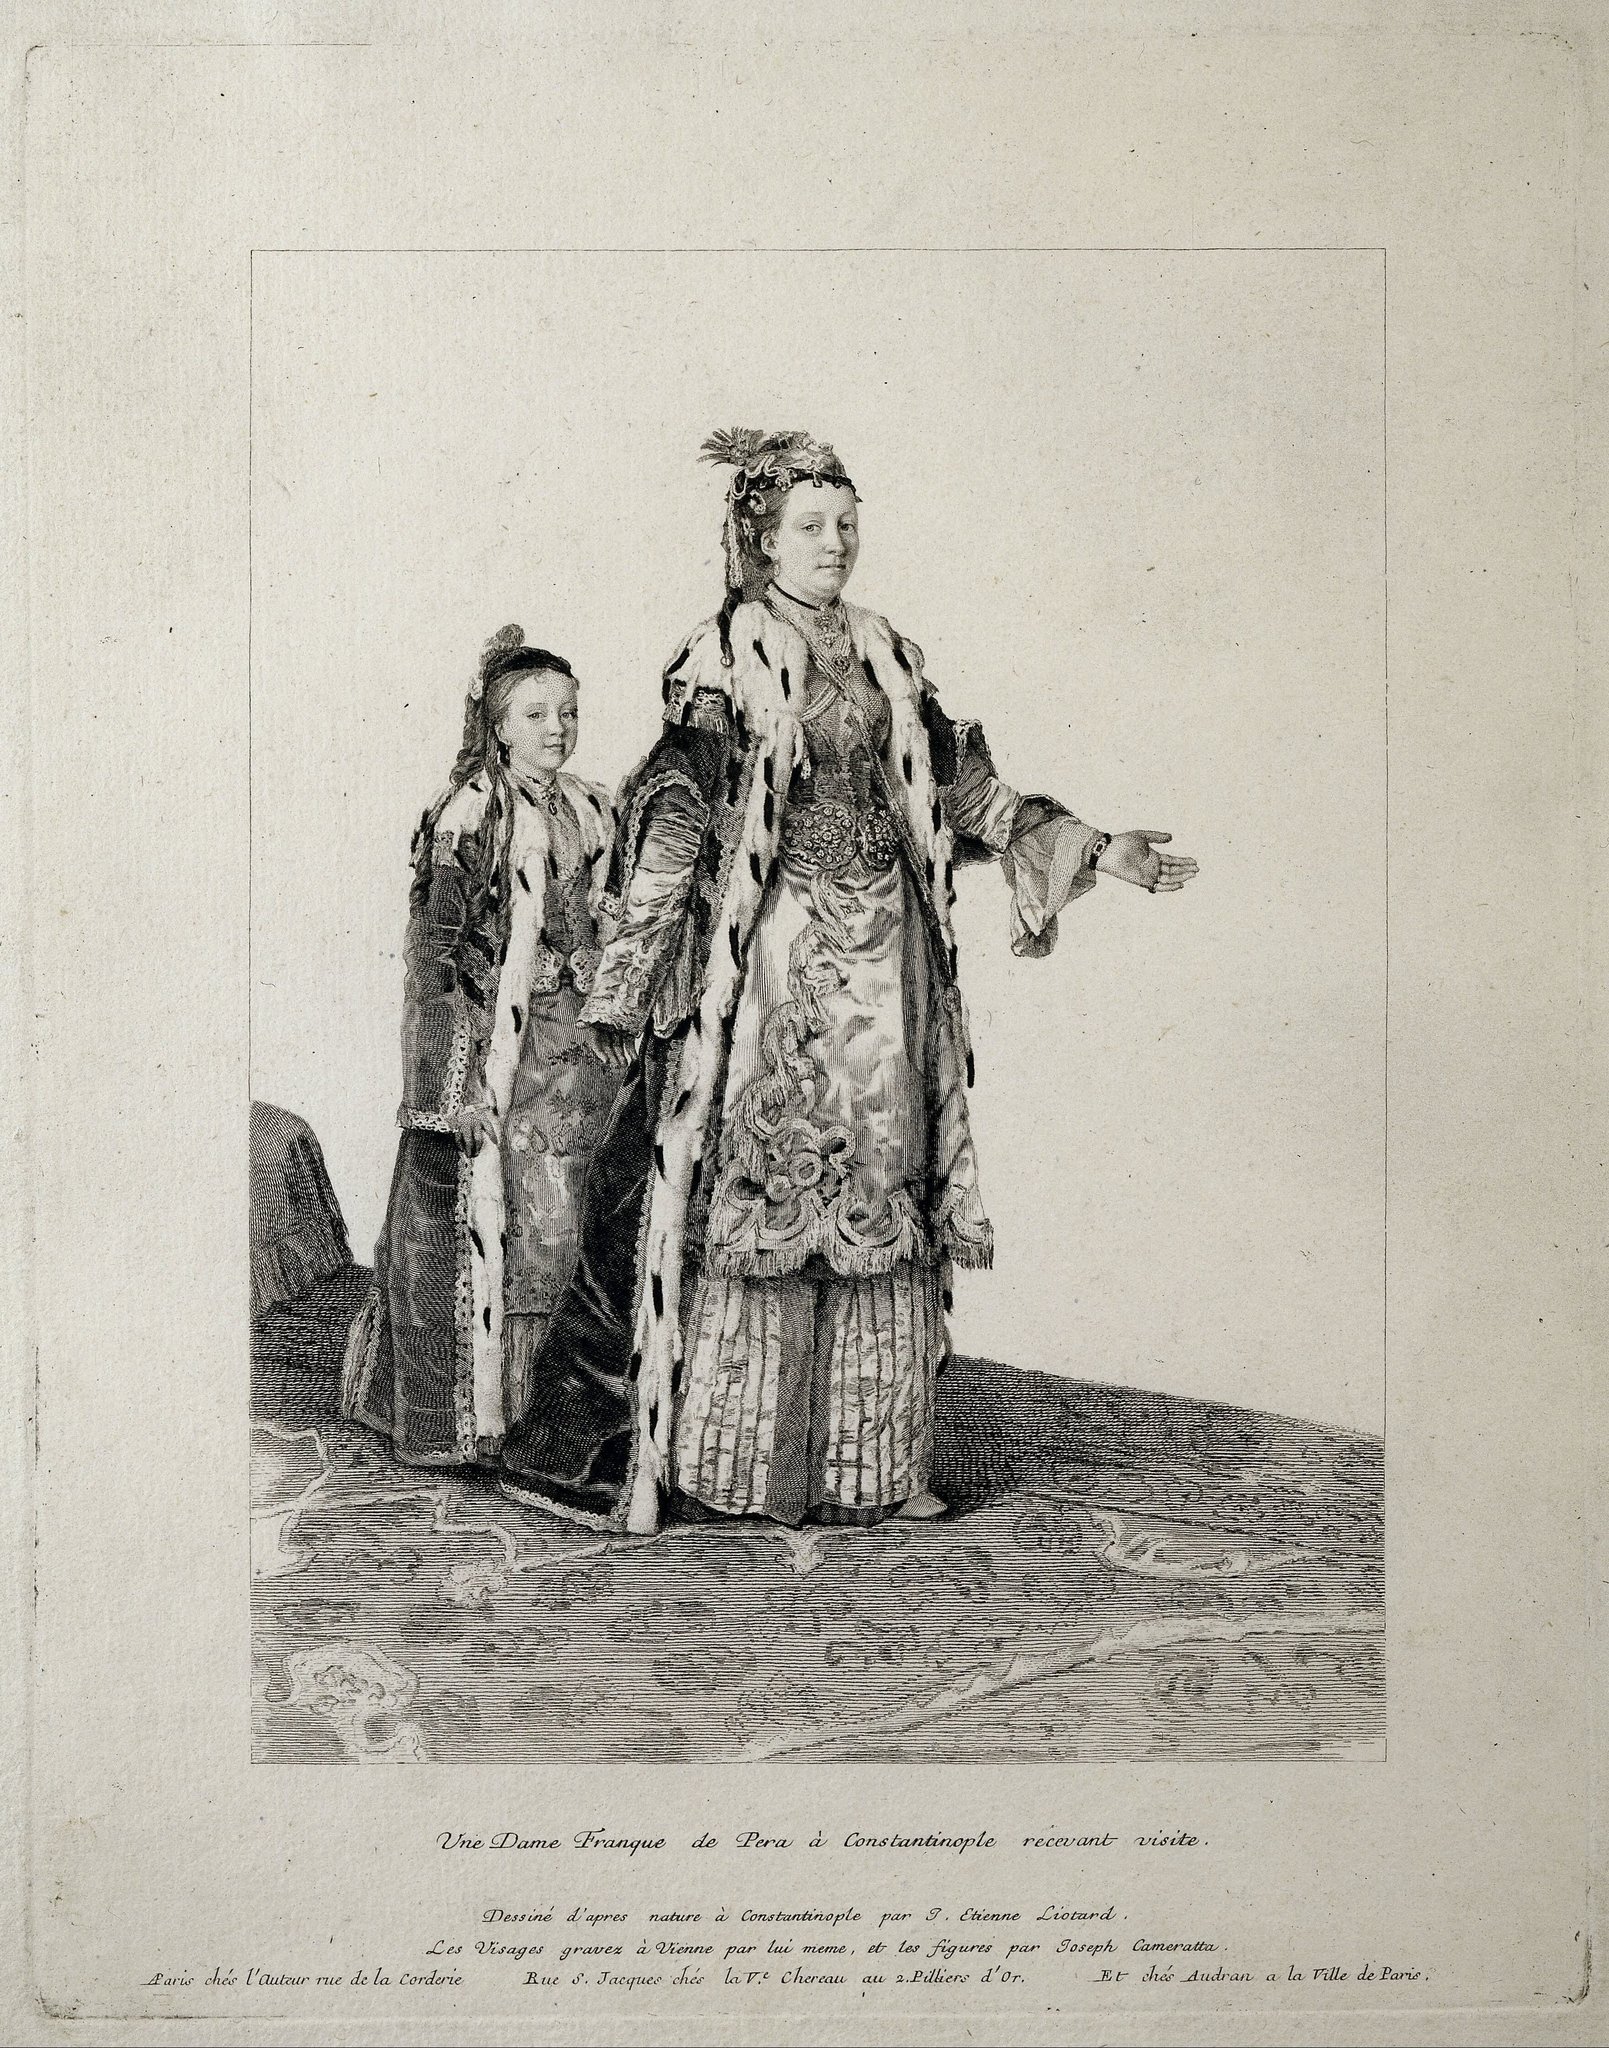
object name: print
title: Een vrouw in Pera ontvangt bezoekers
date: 1745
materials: paper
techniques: engraving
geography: vienna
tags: asiatic races and peoples: turks (+ costume)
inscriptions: collector's mark: Lugt 2228, collector's mark: Lugt 2760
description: Een vrouw van Europese afkomst met haar dochter ontvangt bezoekers in Pera, bij Constantinopel.